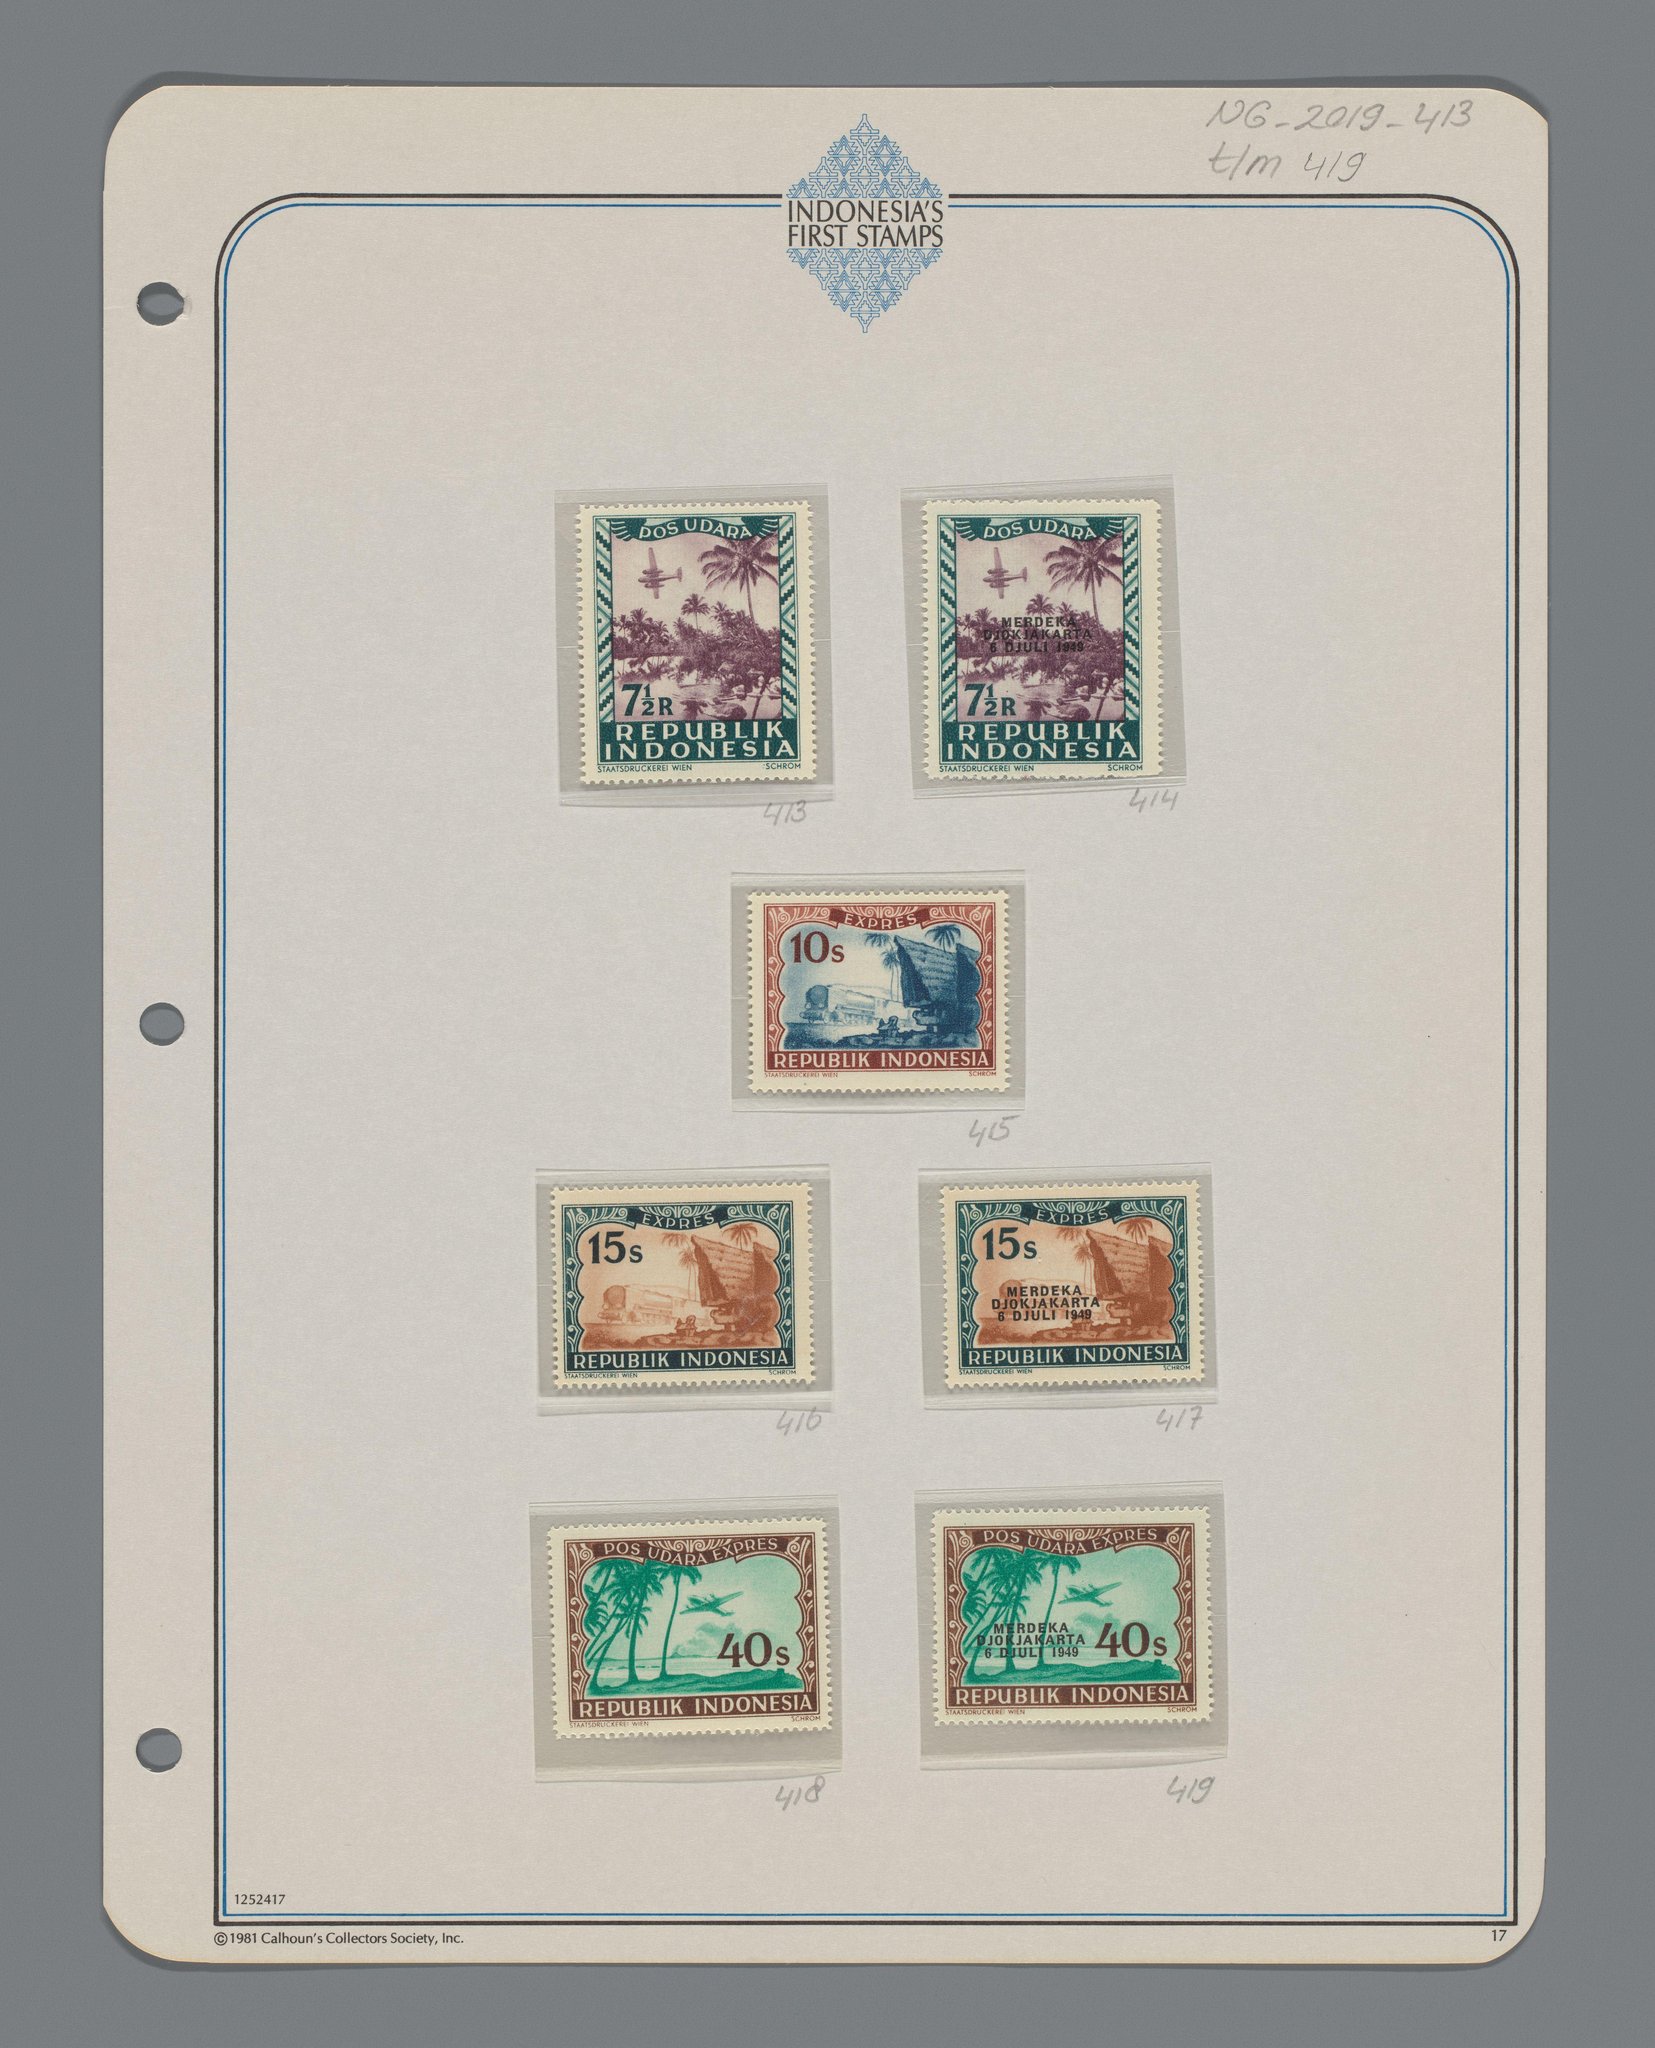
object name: postage stamp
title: Postzegel Republik Indonesia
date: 1949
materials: paper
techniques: photoaquatint, engraving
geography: vienna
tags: indonesia